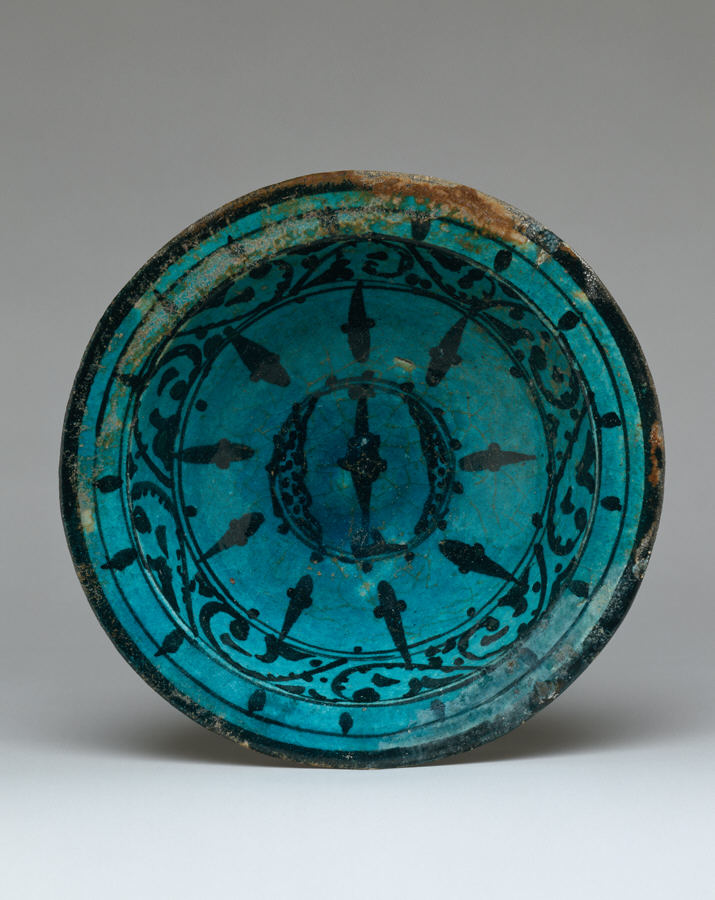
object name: bowl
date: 1101-1200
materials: stonepaste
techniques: painting, underglaze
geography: syria